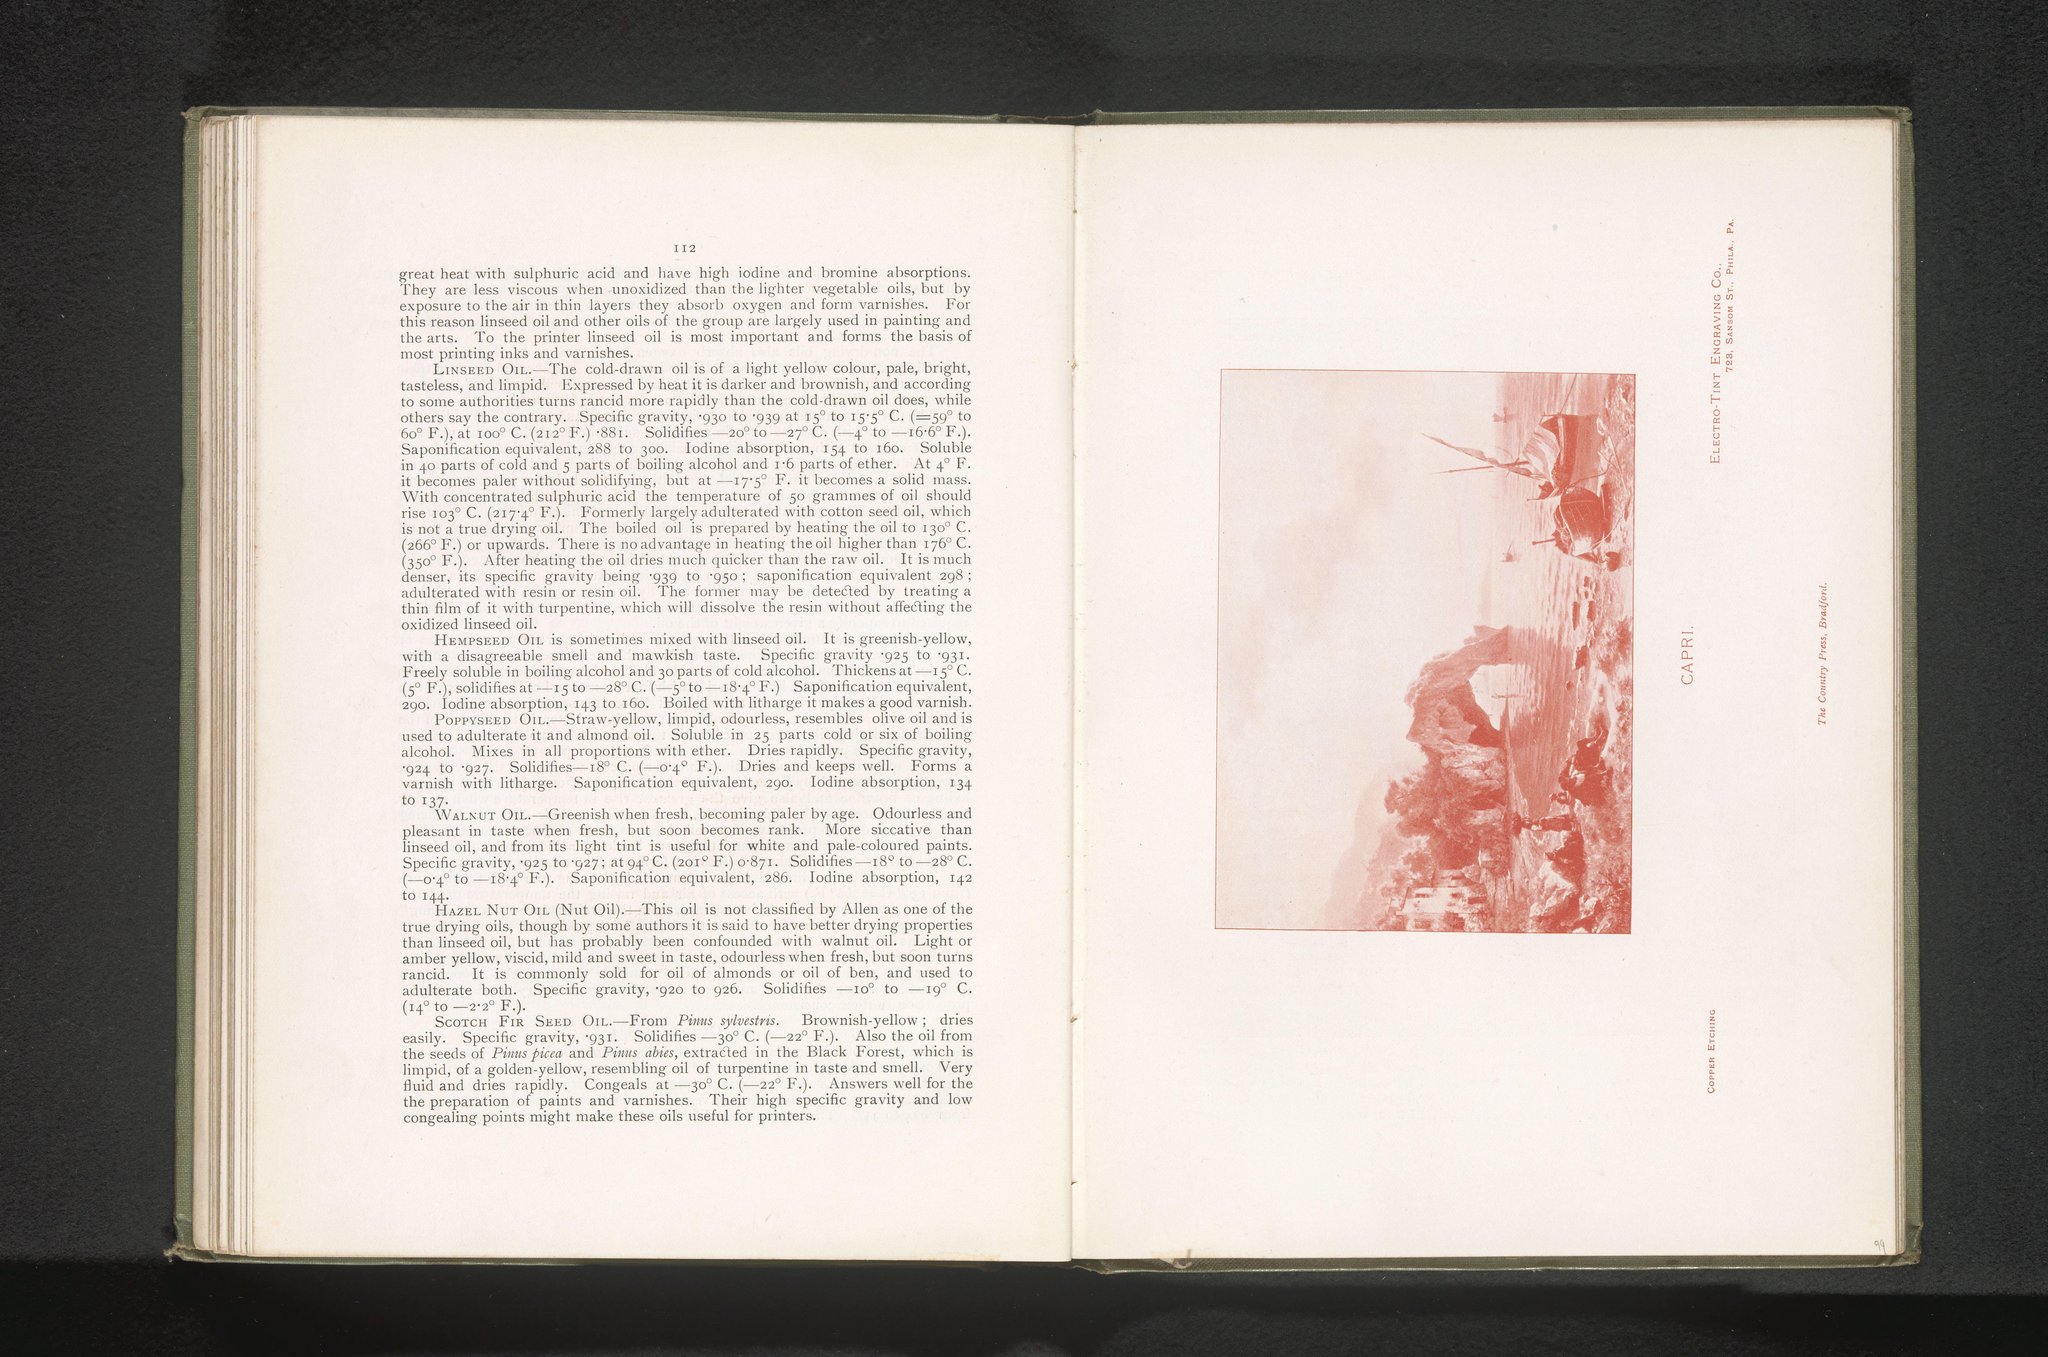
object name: photomechanical print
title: Reproductie van een ontwerp van een zeegezicht bij Capri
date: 1893-1898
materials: paper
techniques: autotype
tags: island (+ landscape with figures, staffage), sea (seascape) (+ landscape with figures, staffage)